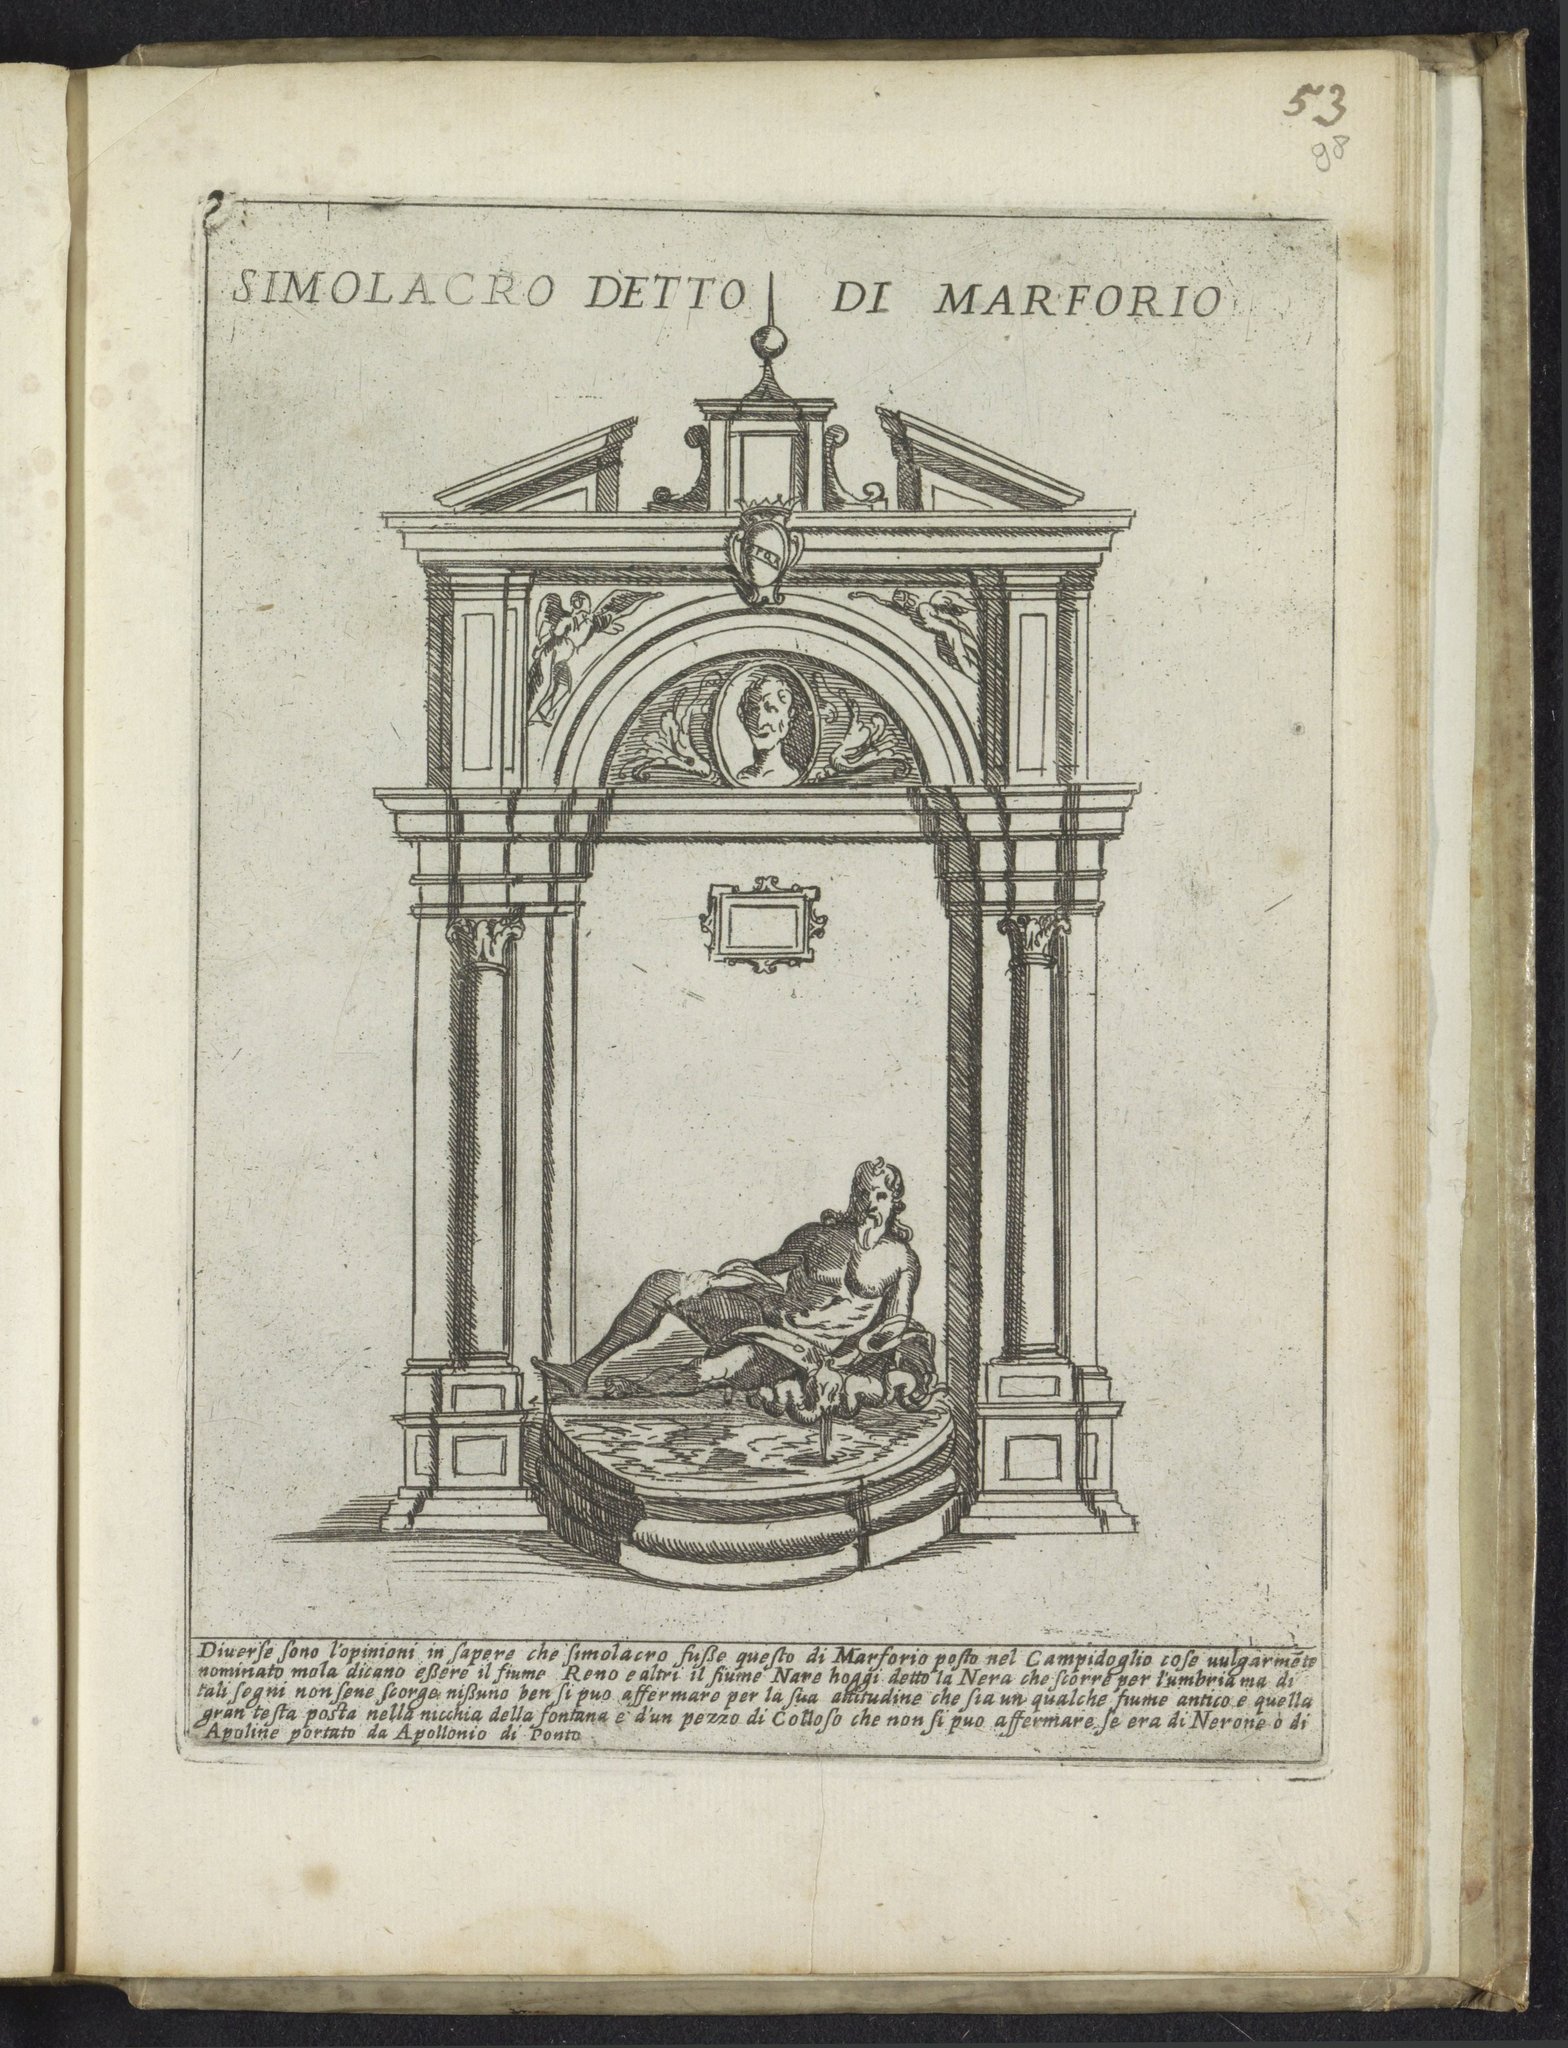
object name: print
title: Simolacro detto di Marforio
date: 1576-1618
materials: paper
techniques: etching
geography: rome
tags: piece of sculpture, reproduction of a piece of sculpture, ornamental fountain, rome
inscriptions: number: ‘53’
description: Sculptuur van Marforio, een van de pratende beelden in Rome. Tekst in het Italiaans onder de voorstelling. De prent maakt deel uit van een album.